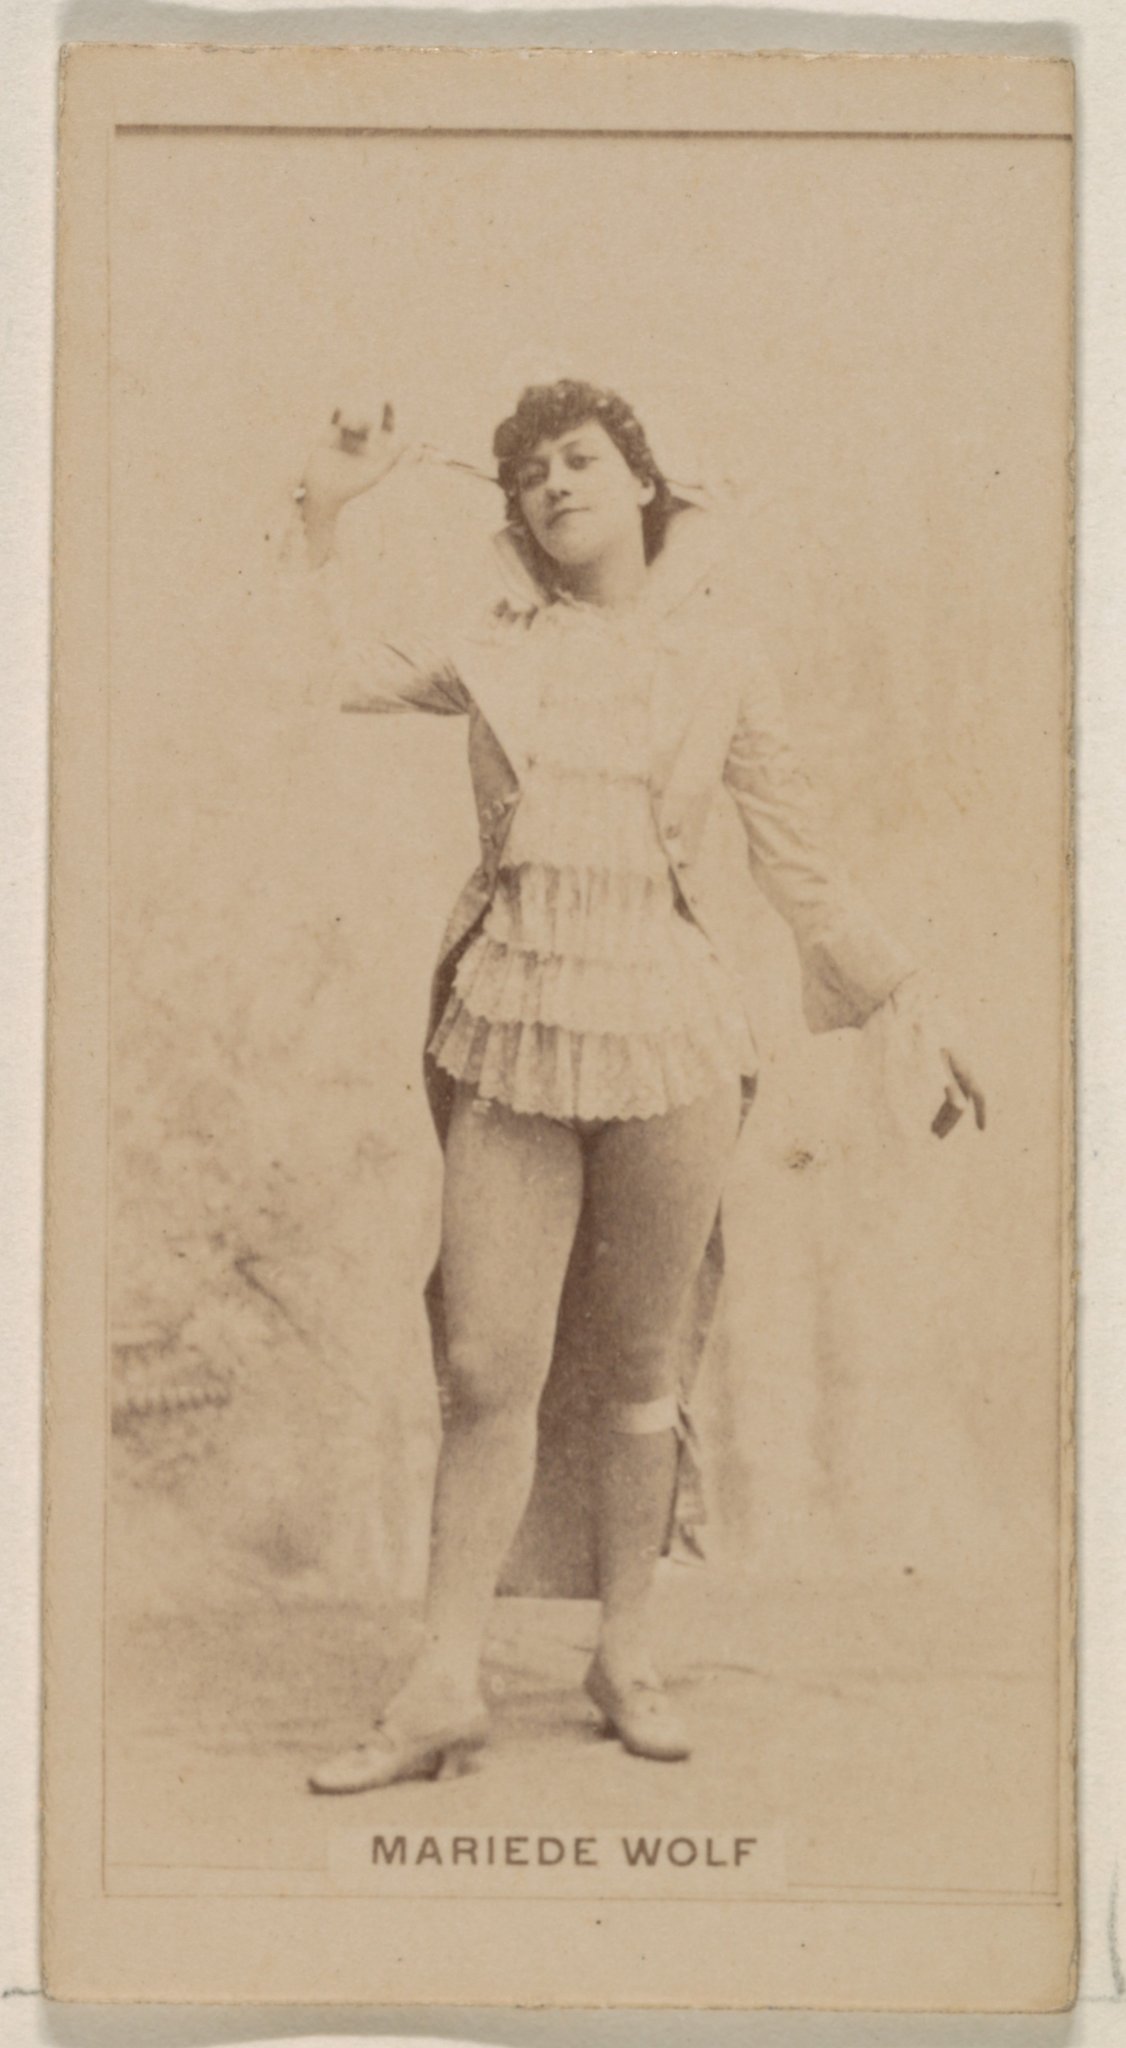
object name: photograph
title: Mariede Wolf, from the Actresses series (N245) issued by Kinney Brothers to promote Sweet Caporal Cigarettes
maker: kinney brothers tobacco company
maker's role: publisher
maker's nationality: american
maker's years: 1869-2011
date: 1890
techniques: albumen silver print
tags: portraits,women,actresses